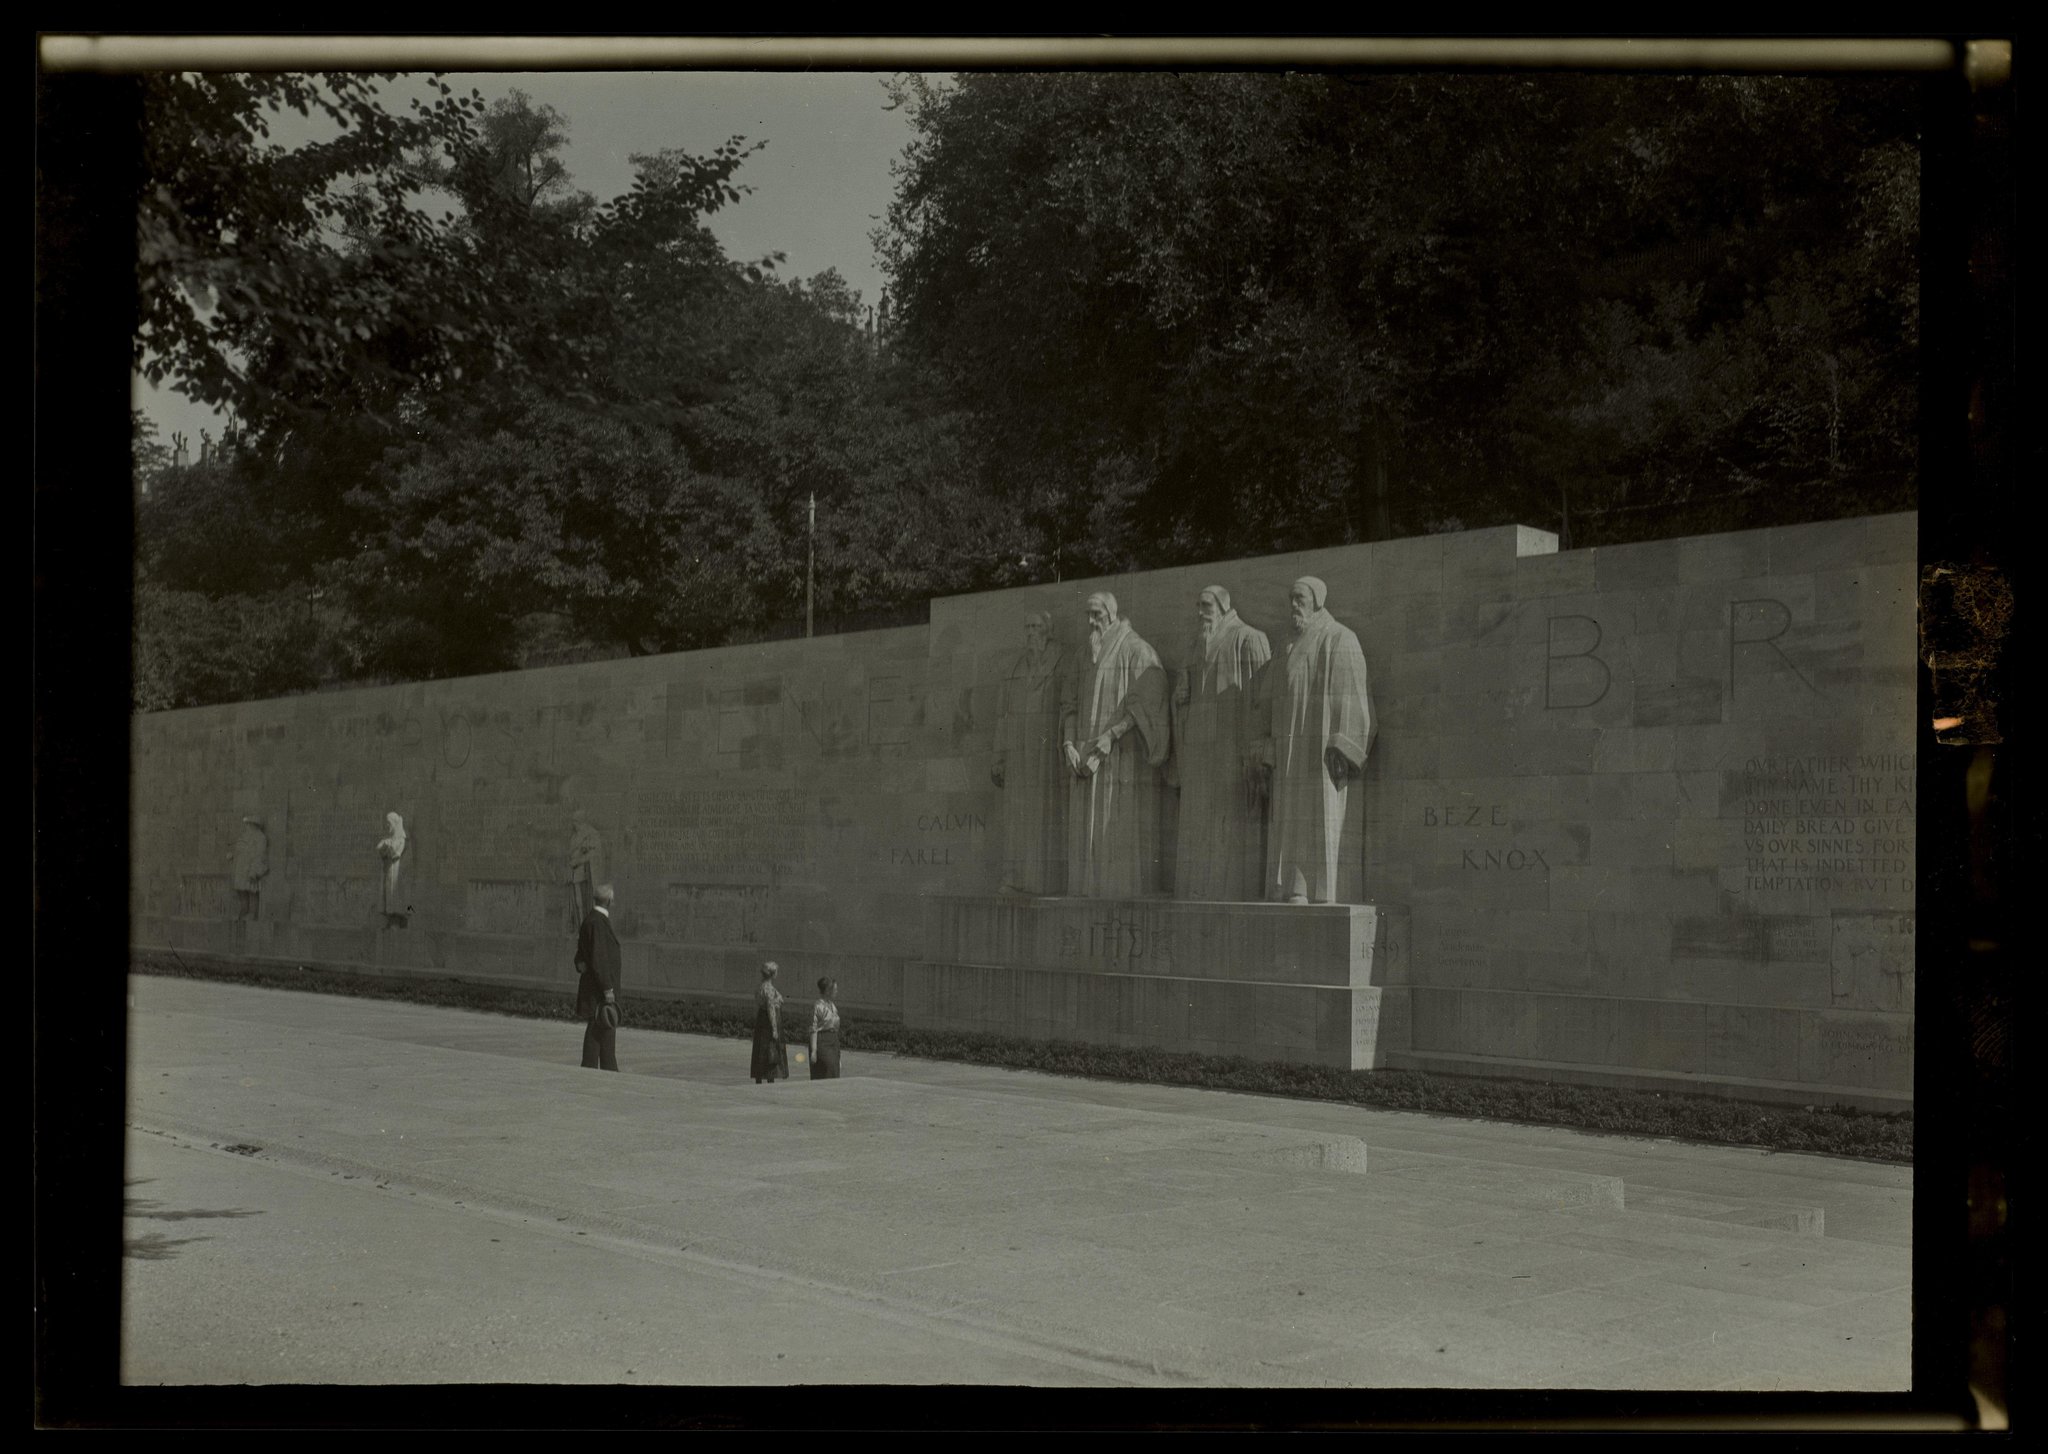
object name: negative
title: Negatief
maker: Anonymous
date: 1907-1935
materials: film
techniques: gelatin silver negative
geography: netherlands